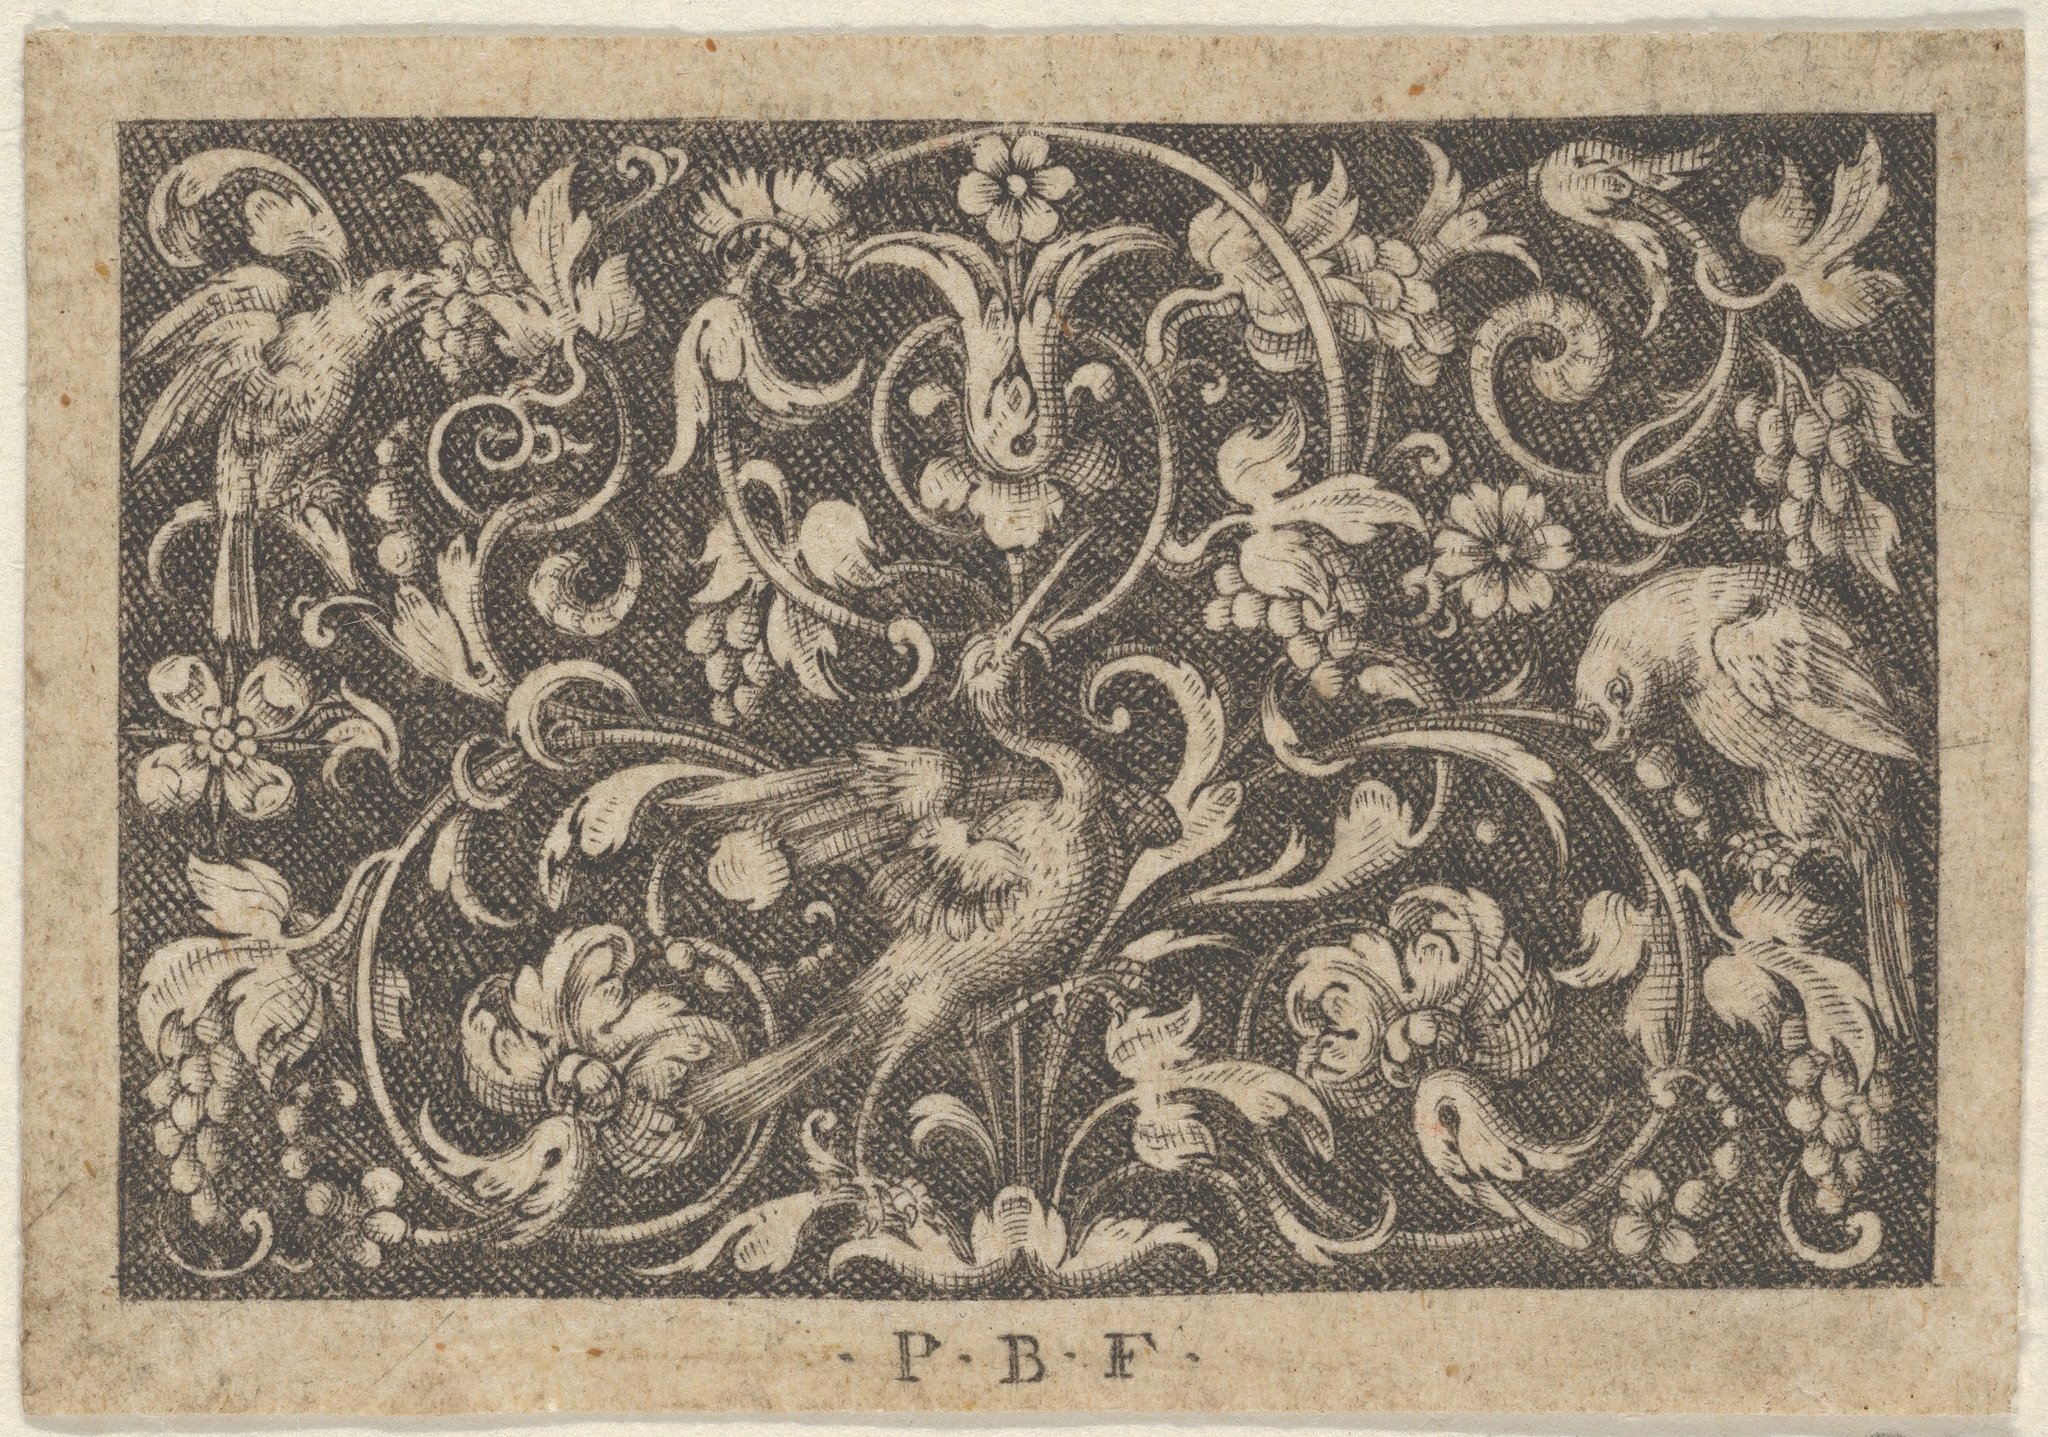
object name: print ornament architecture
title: Horizontal Panel with Three Birds, from Varii Generis Opera Aurifabris Necessaria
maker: paul birckenhultz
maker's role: artist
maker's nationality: german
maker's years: 1561-1639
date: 1600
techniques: engraving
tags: birds,fruit,flowers